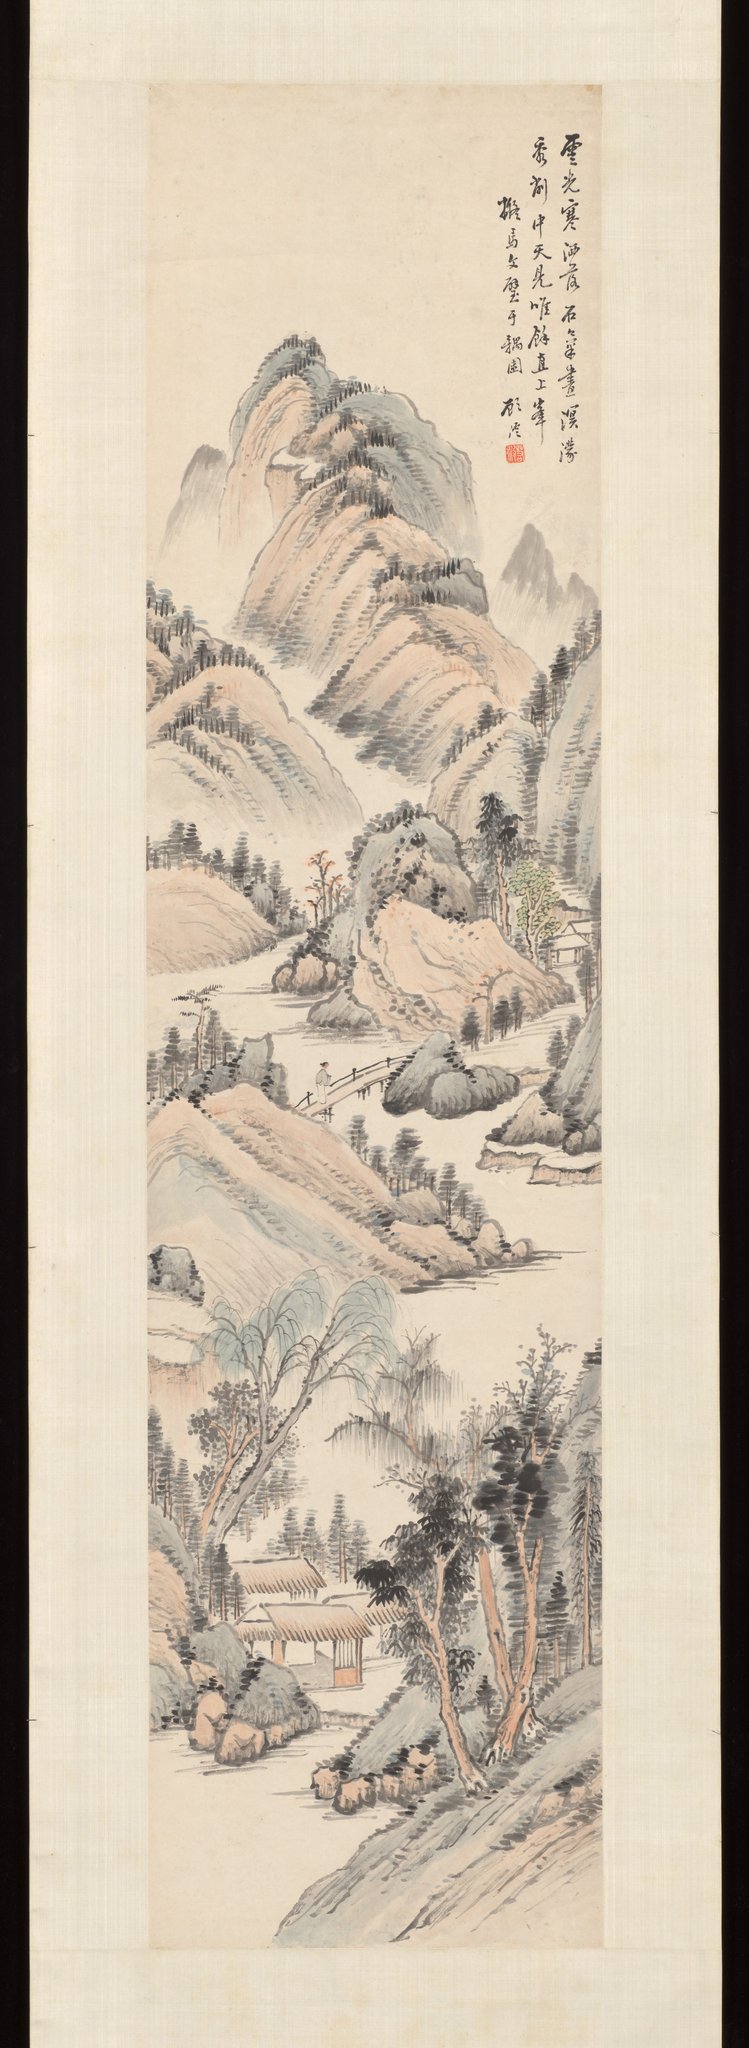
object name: hanging scroll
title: Landscape in the style of Ma Wan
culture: chinese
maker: gu yun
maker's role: artist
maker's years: 1835-1896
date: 1867-1900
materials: ink, paper